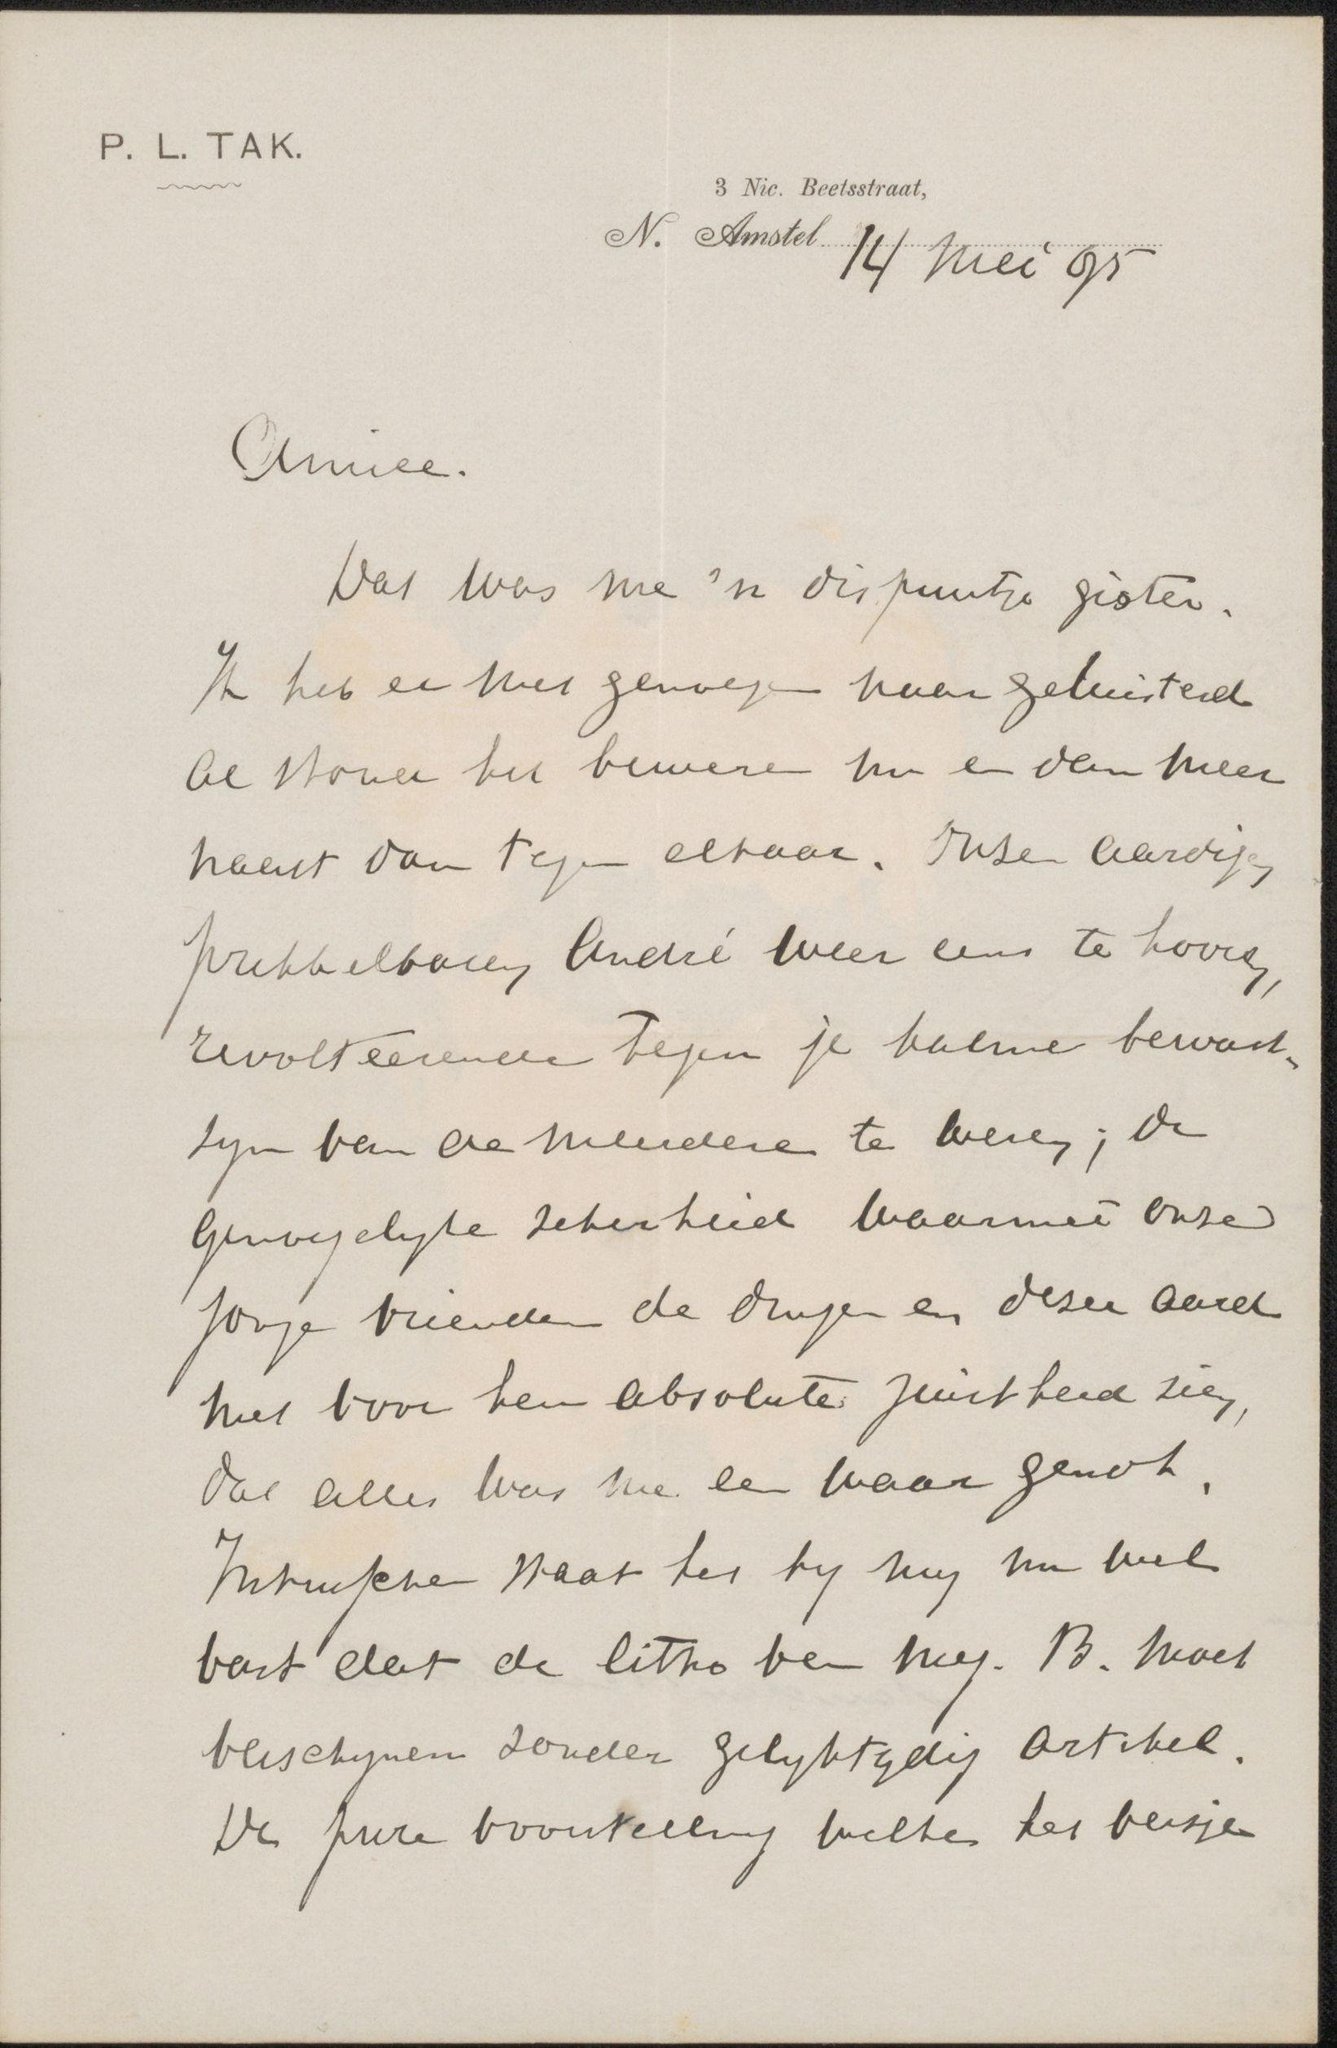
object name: letter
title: Brief aan Jan Veth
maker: pieter lodewijk tak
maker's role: politician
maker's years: 1848-1907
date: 1895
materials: ink, paper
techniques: pen, printing, writing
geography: nieuwer-amstel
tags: dordrecht, amsterdam, painter, print maker, draughtsman, designer, jan veth, nelly bodenheim, andré jolles, the graphic arts, printed matter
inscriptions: watermark, collector's mark: ‘RPK’